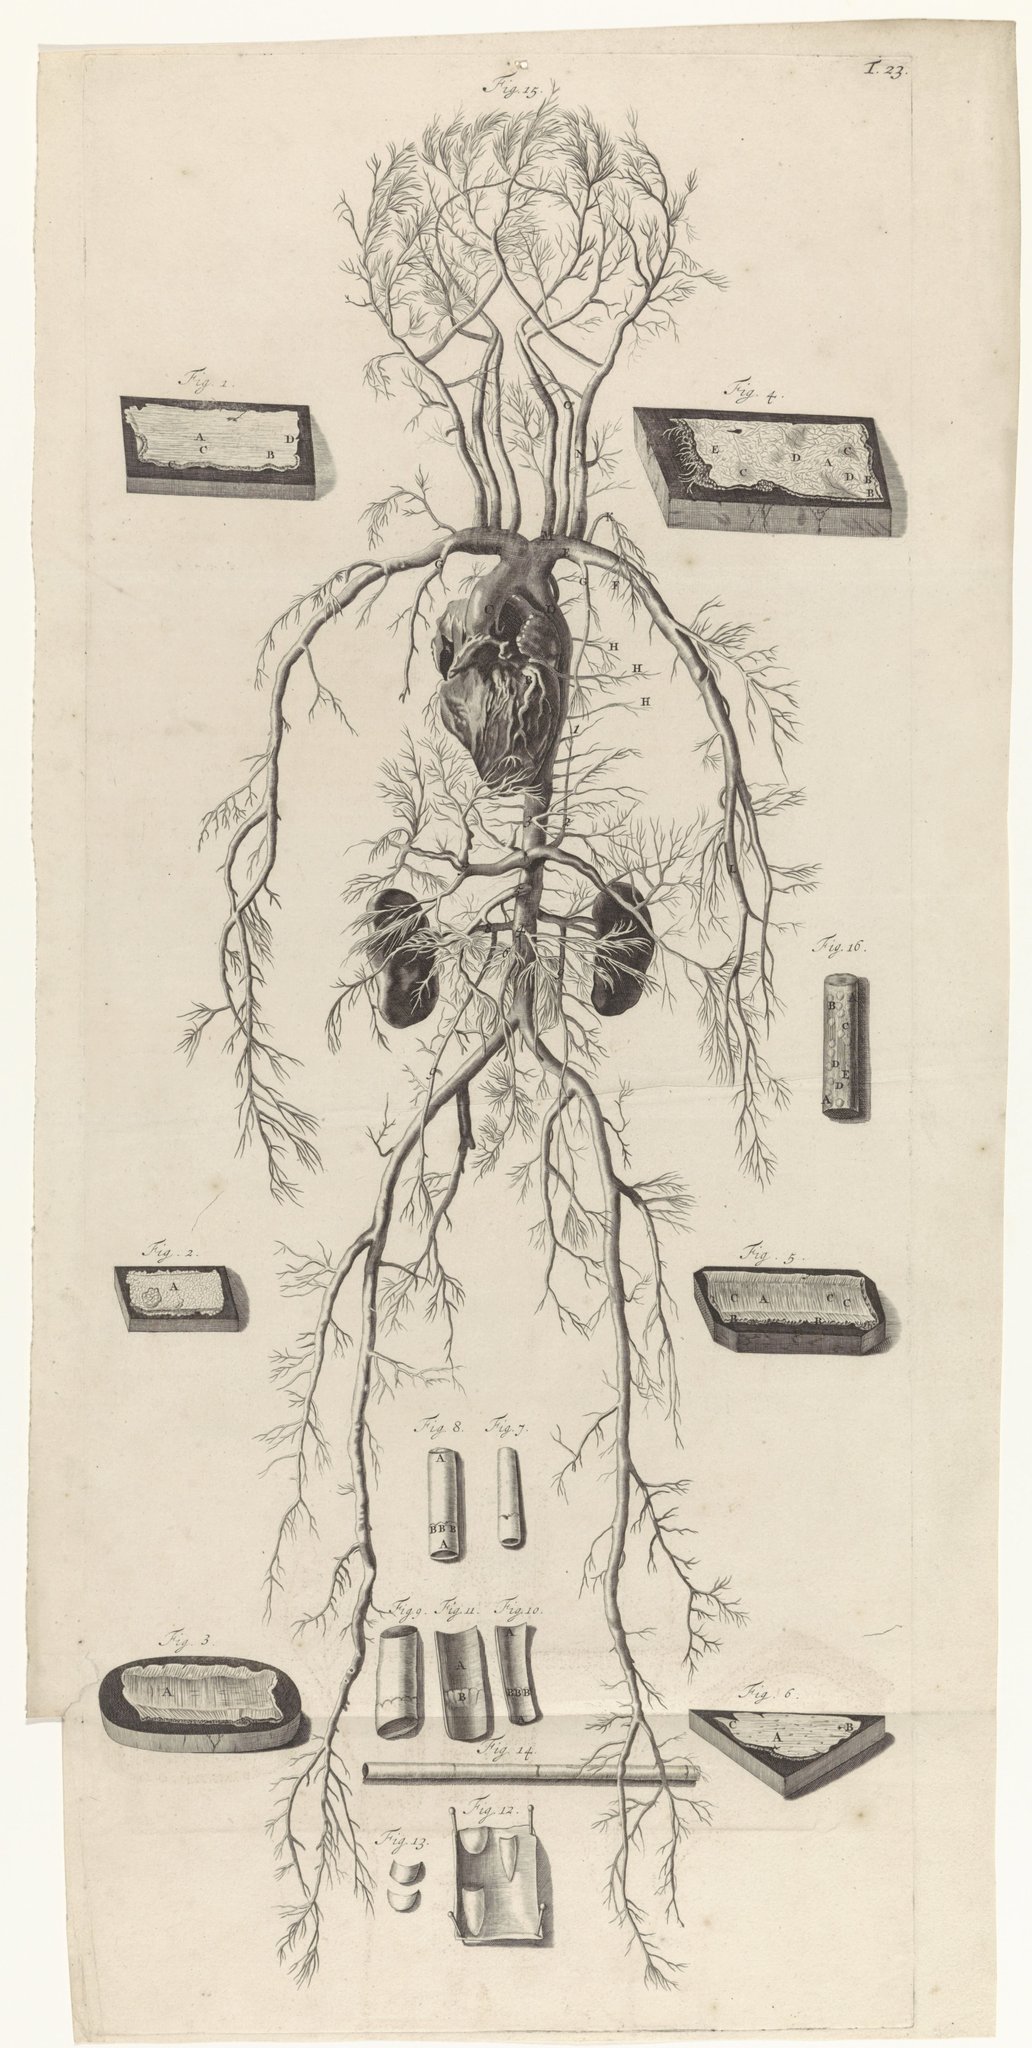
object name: print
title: Anatomische studie van de bloedvaten en de bloedsomloop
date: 1685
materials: paper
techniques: engraving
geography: amsterdam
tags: blood circulation, anatomical model of the arteries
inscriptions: collector's mark: Lugt 2228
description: Boekillustratie voor Bidloo, Godefridus. Anatomia humani corporis centum & quinque tabulis, per art. G. de Lairesse ad vivum delineatis, de monstrata, veterum recentiorumque inventis explicata plurimisque, hactenus non detectis, illustrata. Amsterdam: Weduwe Joannes van Someren, Hendrick Boom en erven Dirk Boom, 1685.